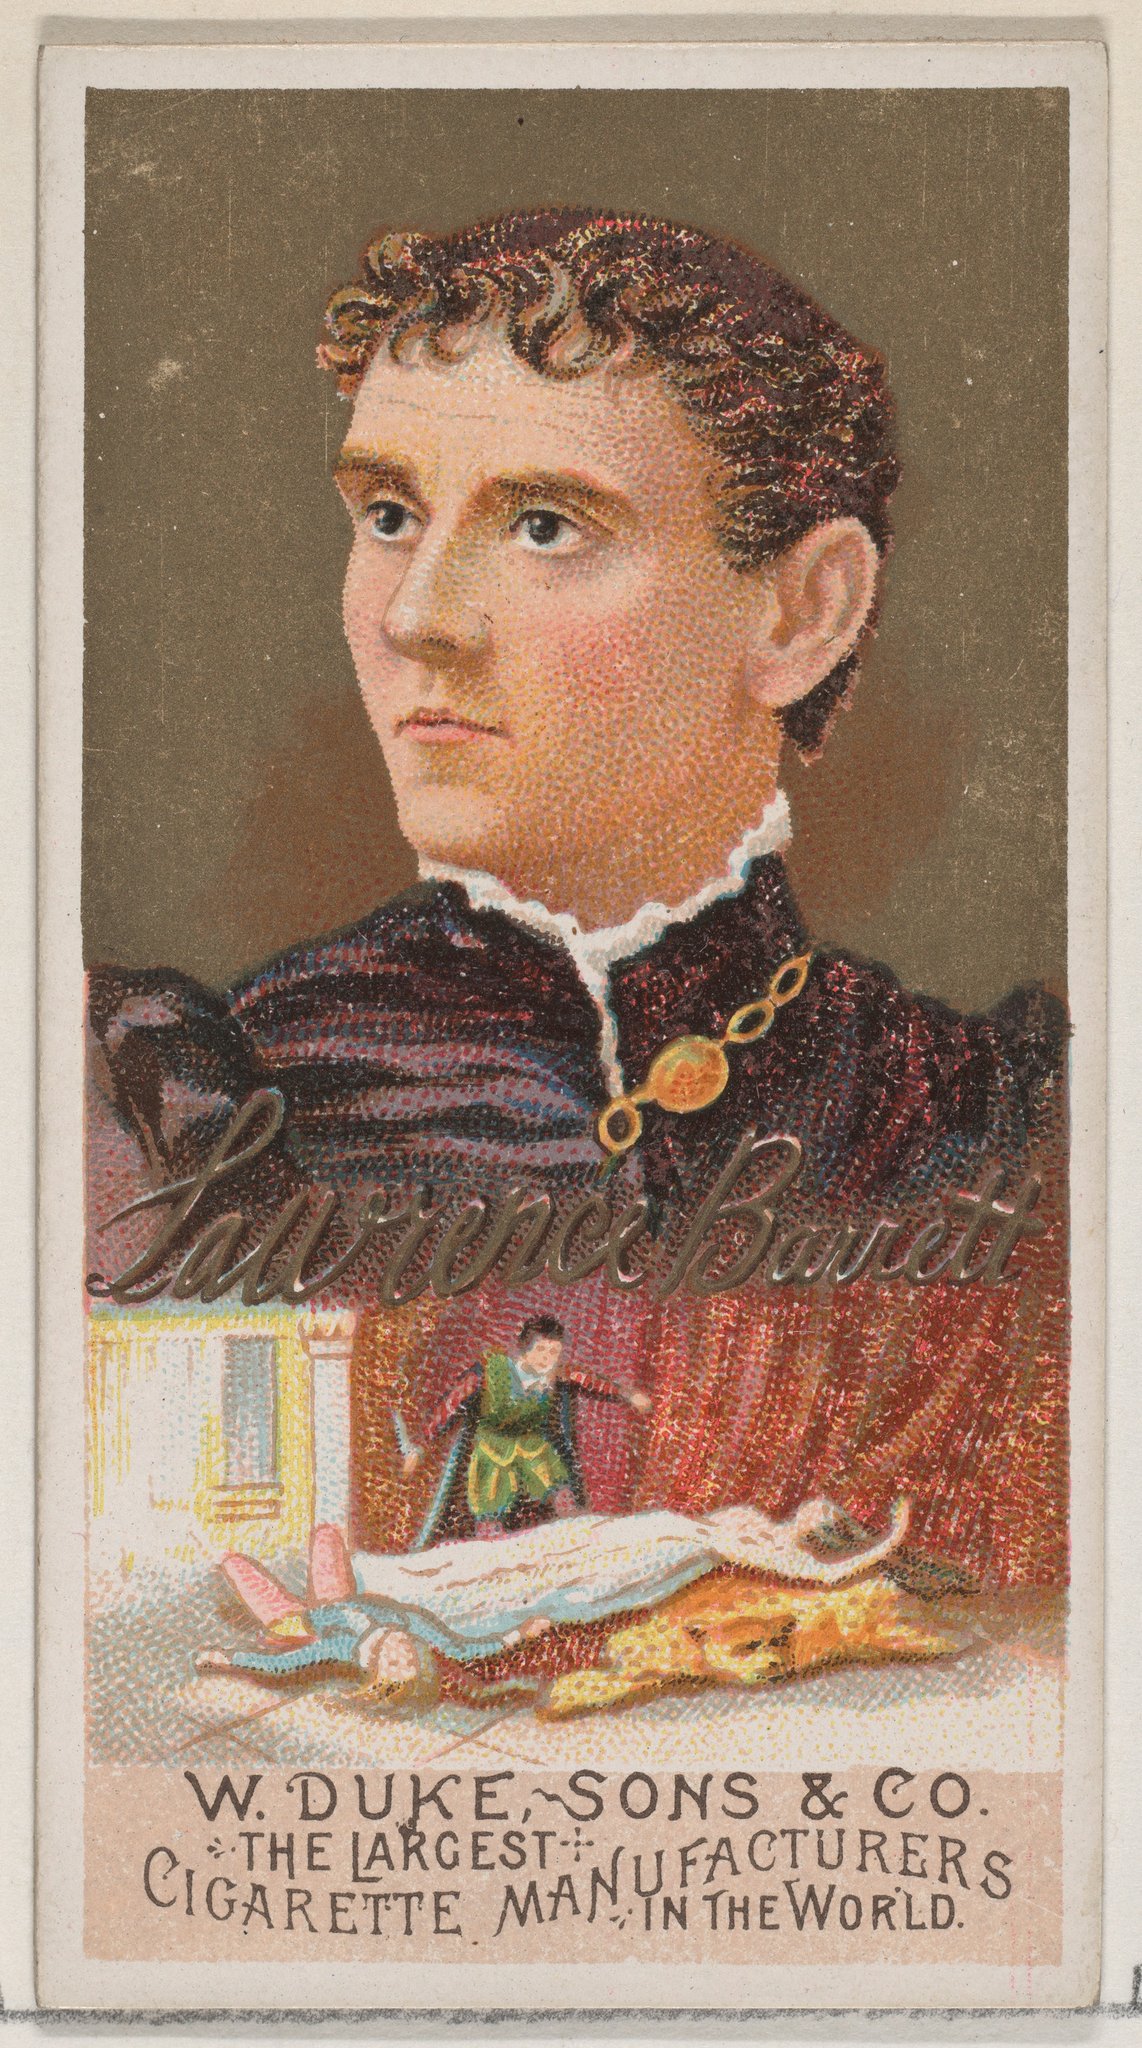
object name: print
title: Lawrence Barrett, from the series Great Americans (N76) for Duke brand cigarettes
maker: w. duke, sons & co.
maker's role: publisher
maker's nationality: american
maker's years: 1870-1920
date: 1888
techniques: color lithograph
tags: men